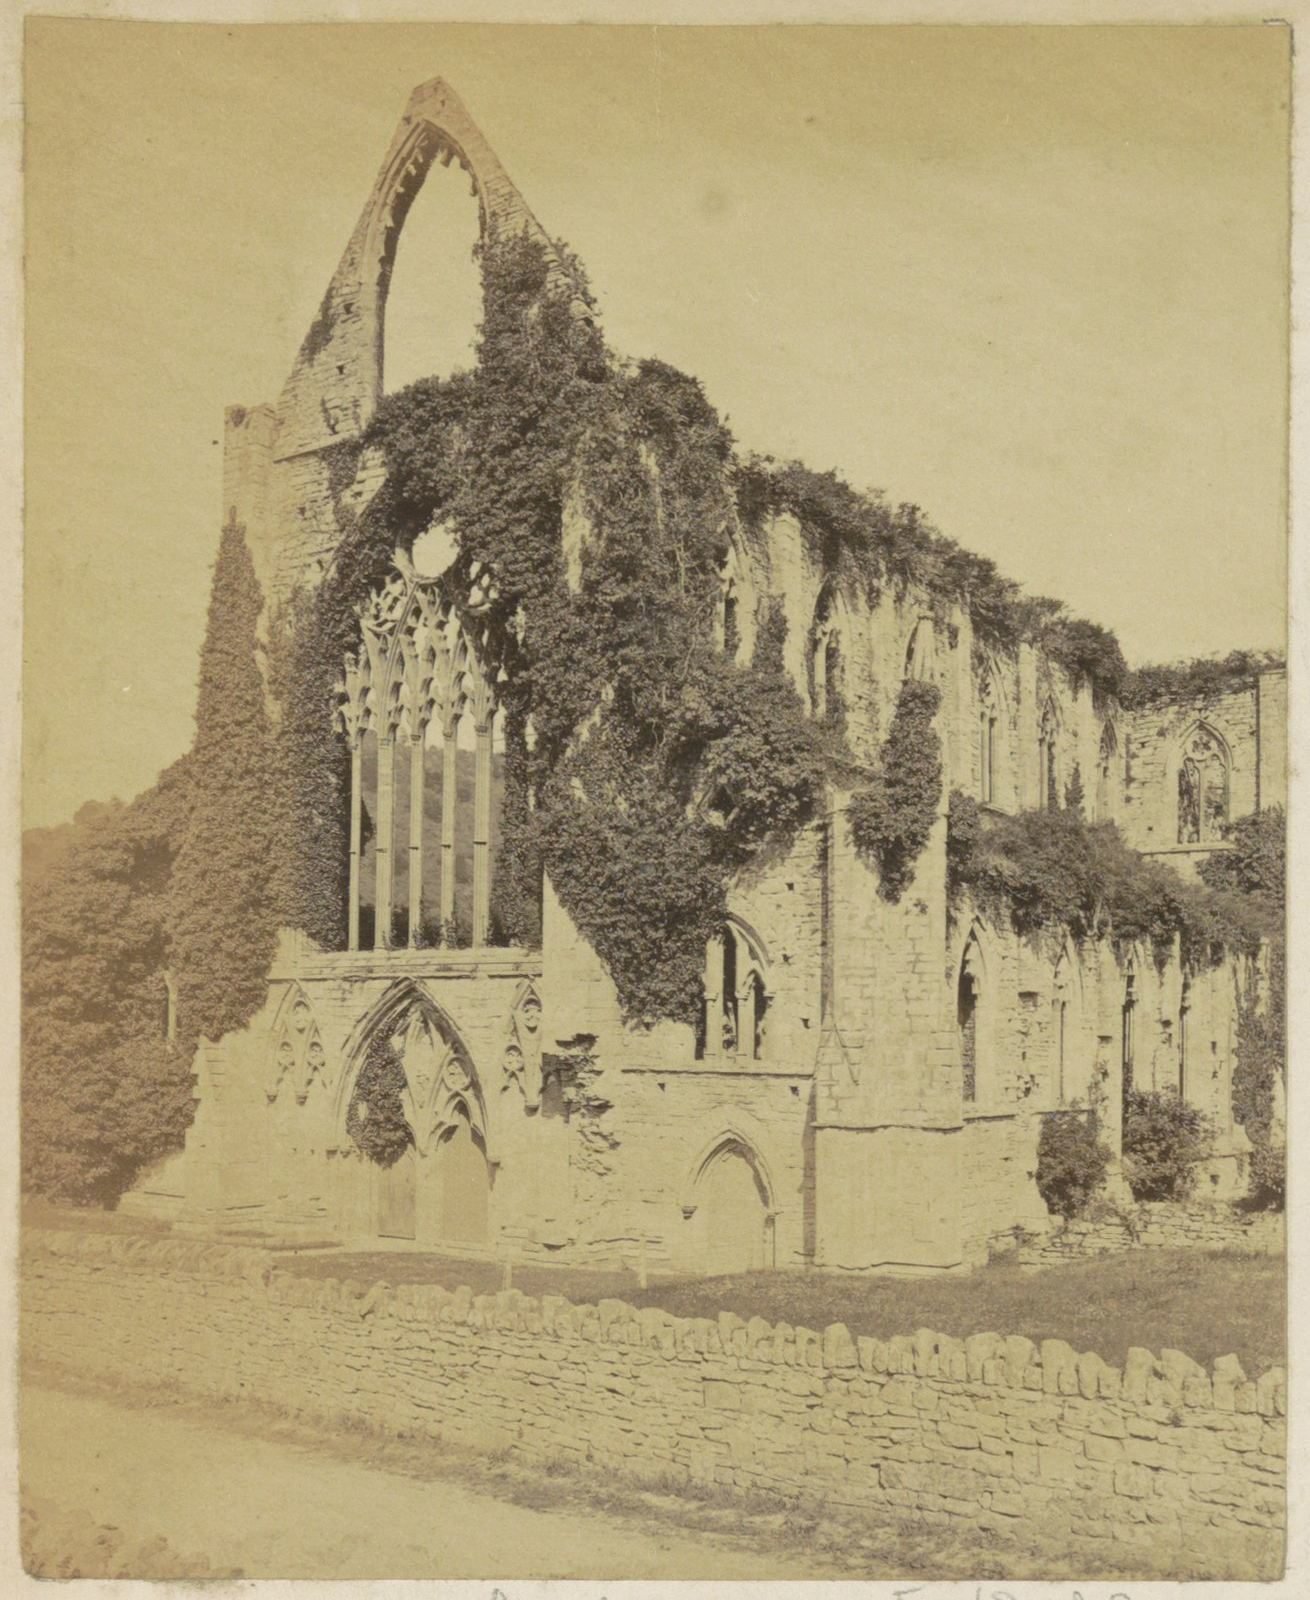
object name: photograph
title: Ruïne van Tintern Abbey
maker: Anonymous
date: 1850-1870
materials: paper, photographic support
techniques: albumen print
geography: tintern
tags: ruin of a dwelling, house, castle, etc.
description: Onderdeel van Album met foto's van bezienswaardigheden en landschappen in Engeland en van kunst.